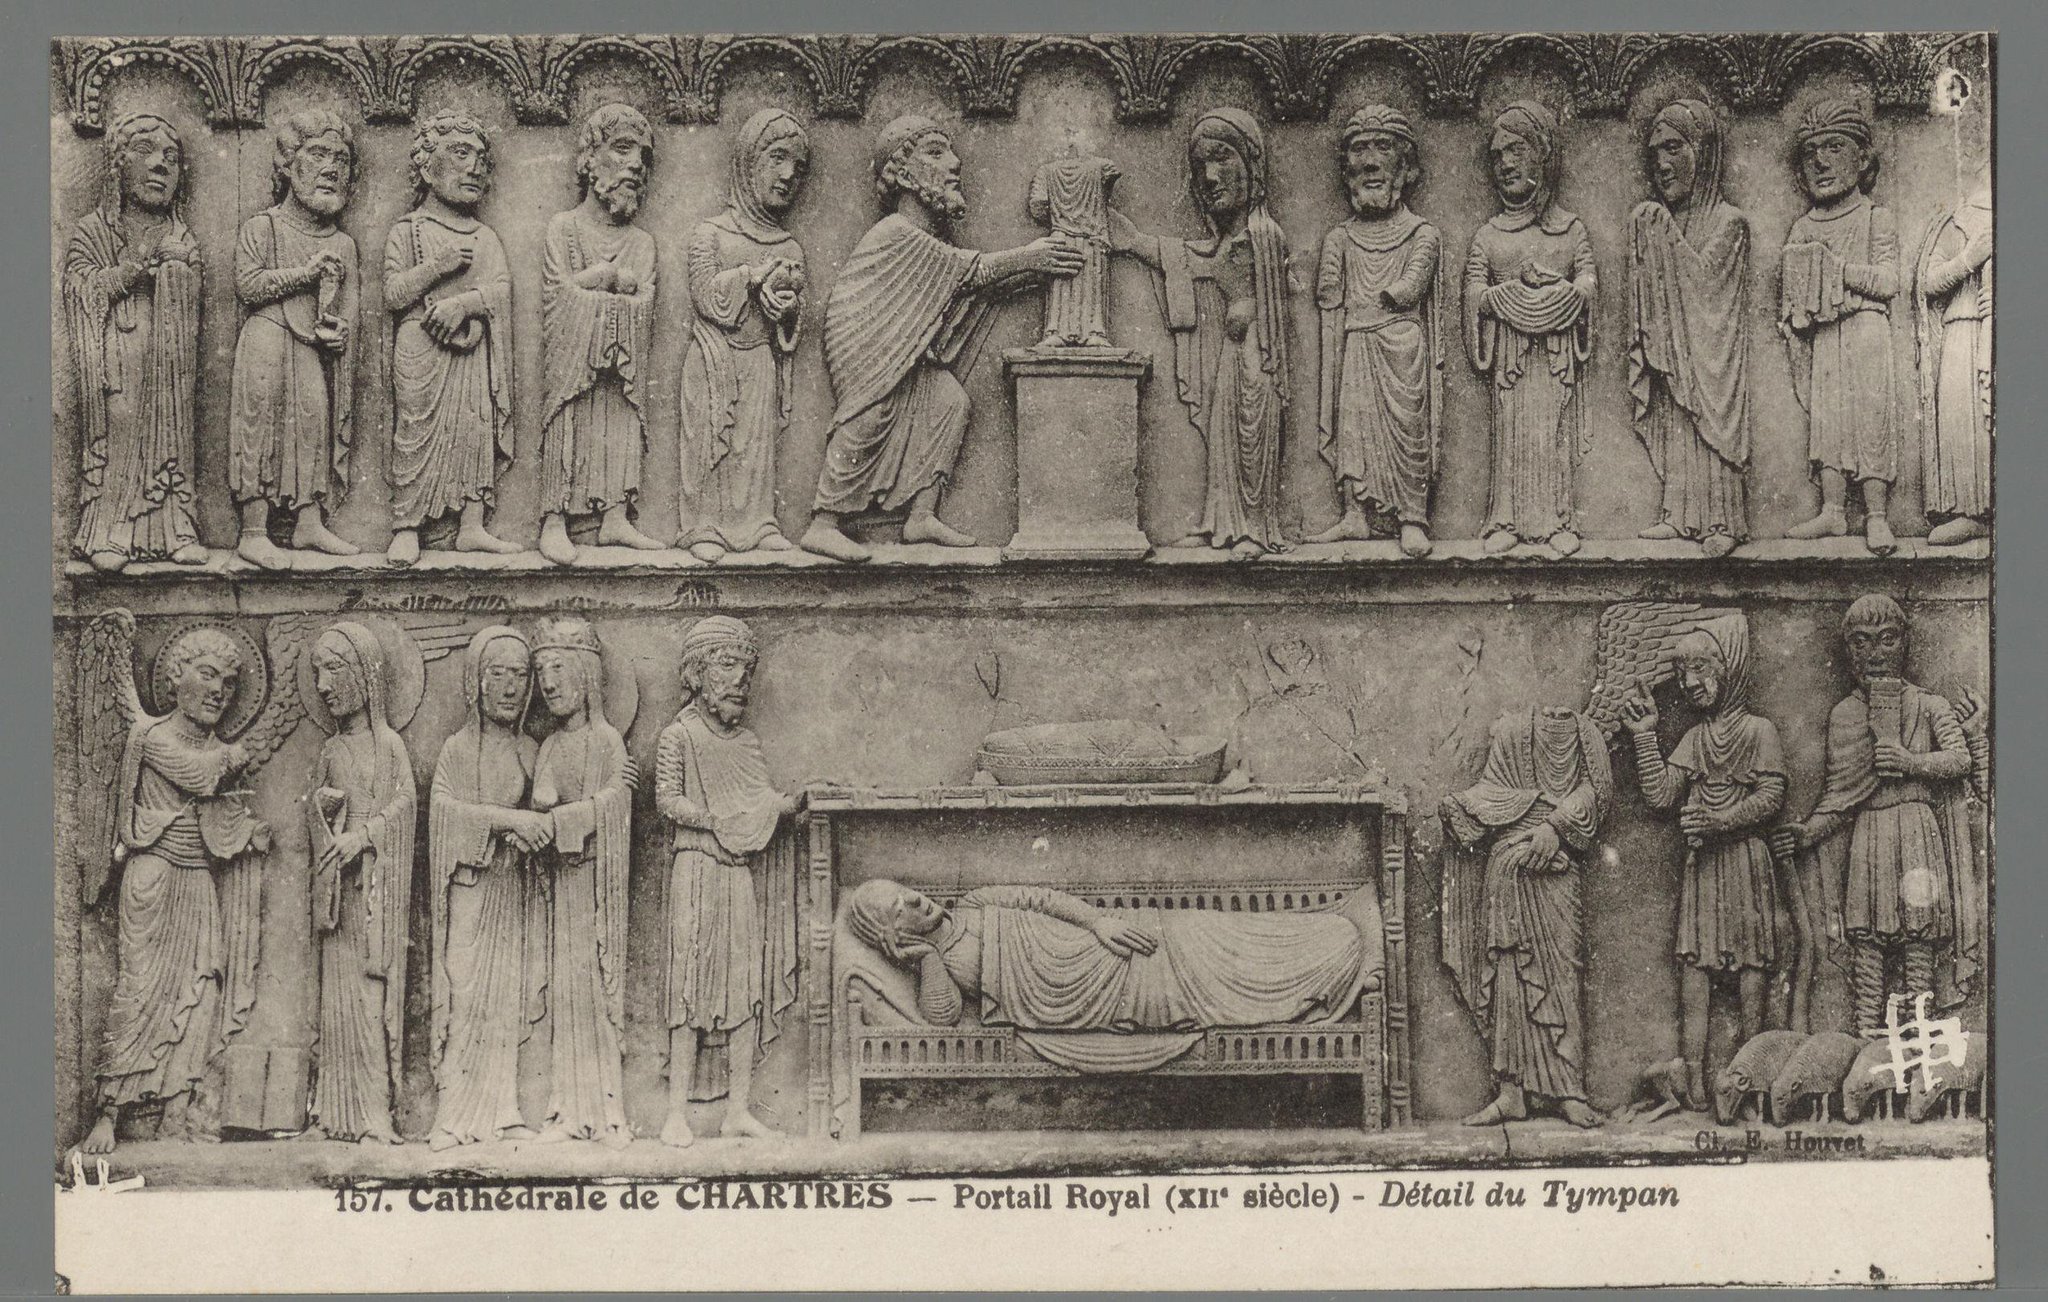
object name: photomechanical print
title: Cathédrale de Chartres - Portail Royal (XIIe siècle). Détail du Tympan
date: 1903-1930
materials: cardboard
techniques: photograph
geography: chartres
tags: church (exterior), statues, paintings, etc. ~ objects of worship in roman religion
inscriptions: collector's mark: ‘AFE v S’, monogram: ‘EH’